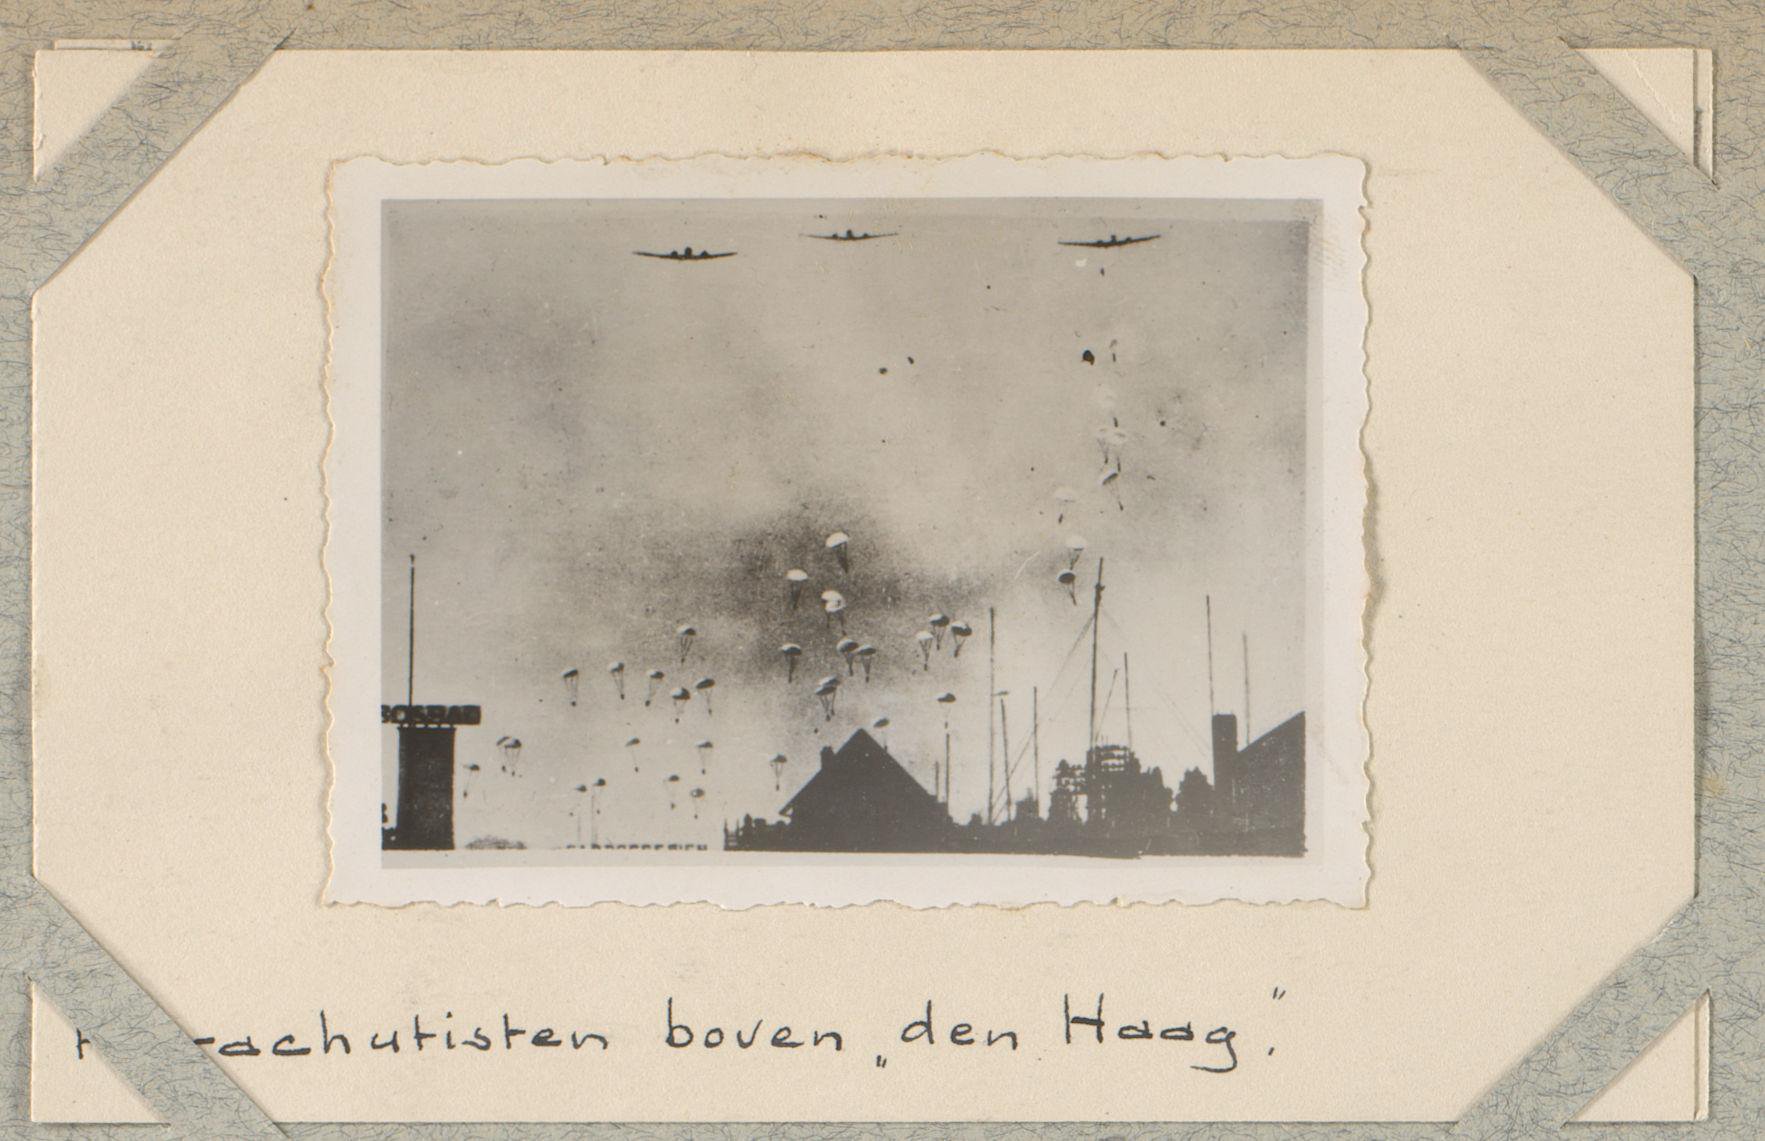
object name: photograph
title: Landende parachutisten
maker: j. nolte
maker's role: fotograaf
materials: photographic support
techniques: gelatin silver print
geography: the hague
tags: warfare; military affairs (+ during the battle), the hague, rotterdam blitz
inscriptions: annotation: ‘Parachutisten bij Slierecht.’